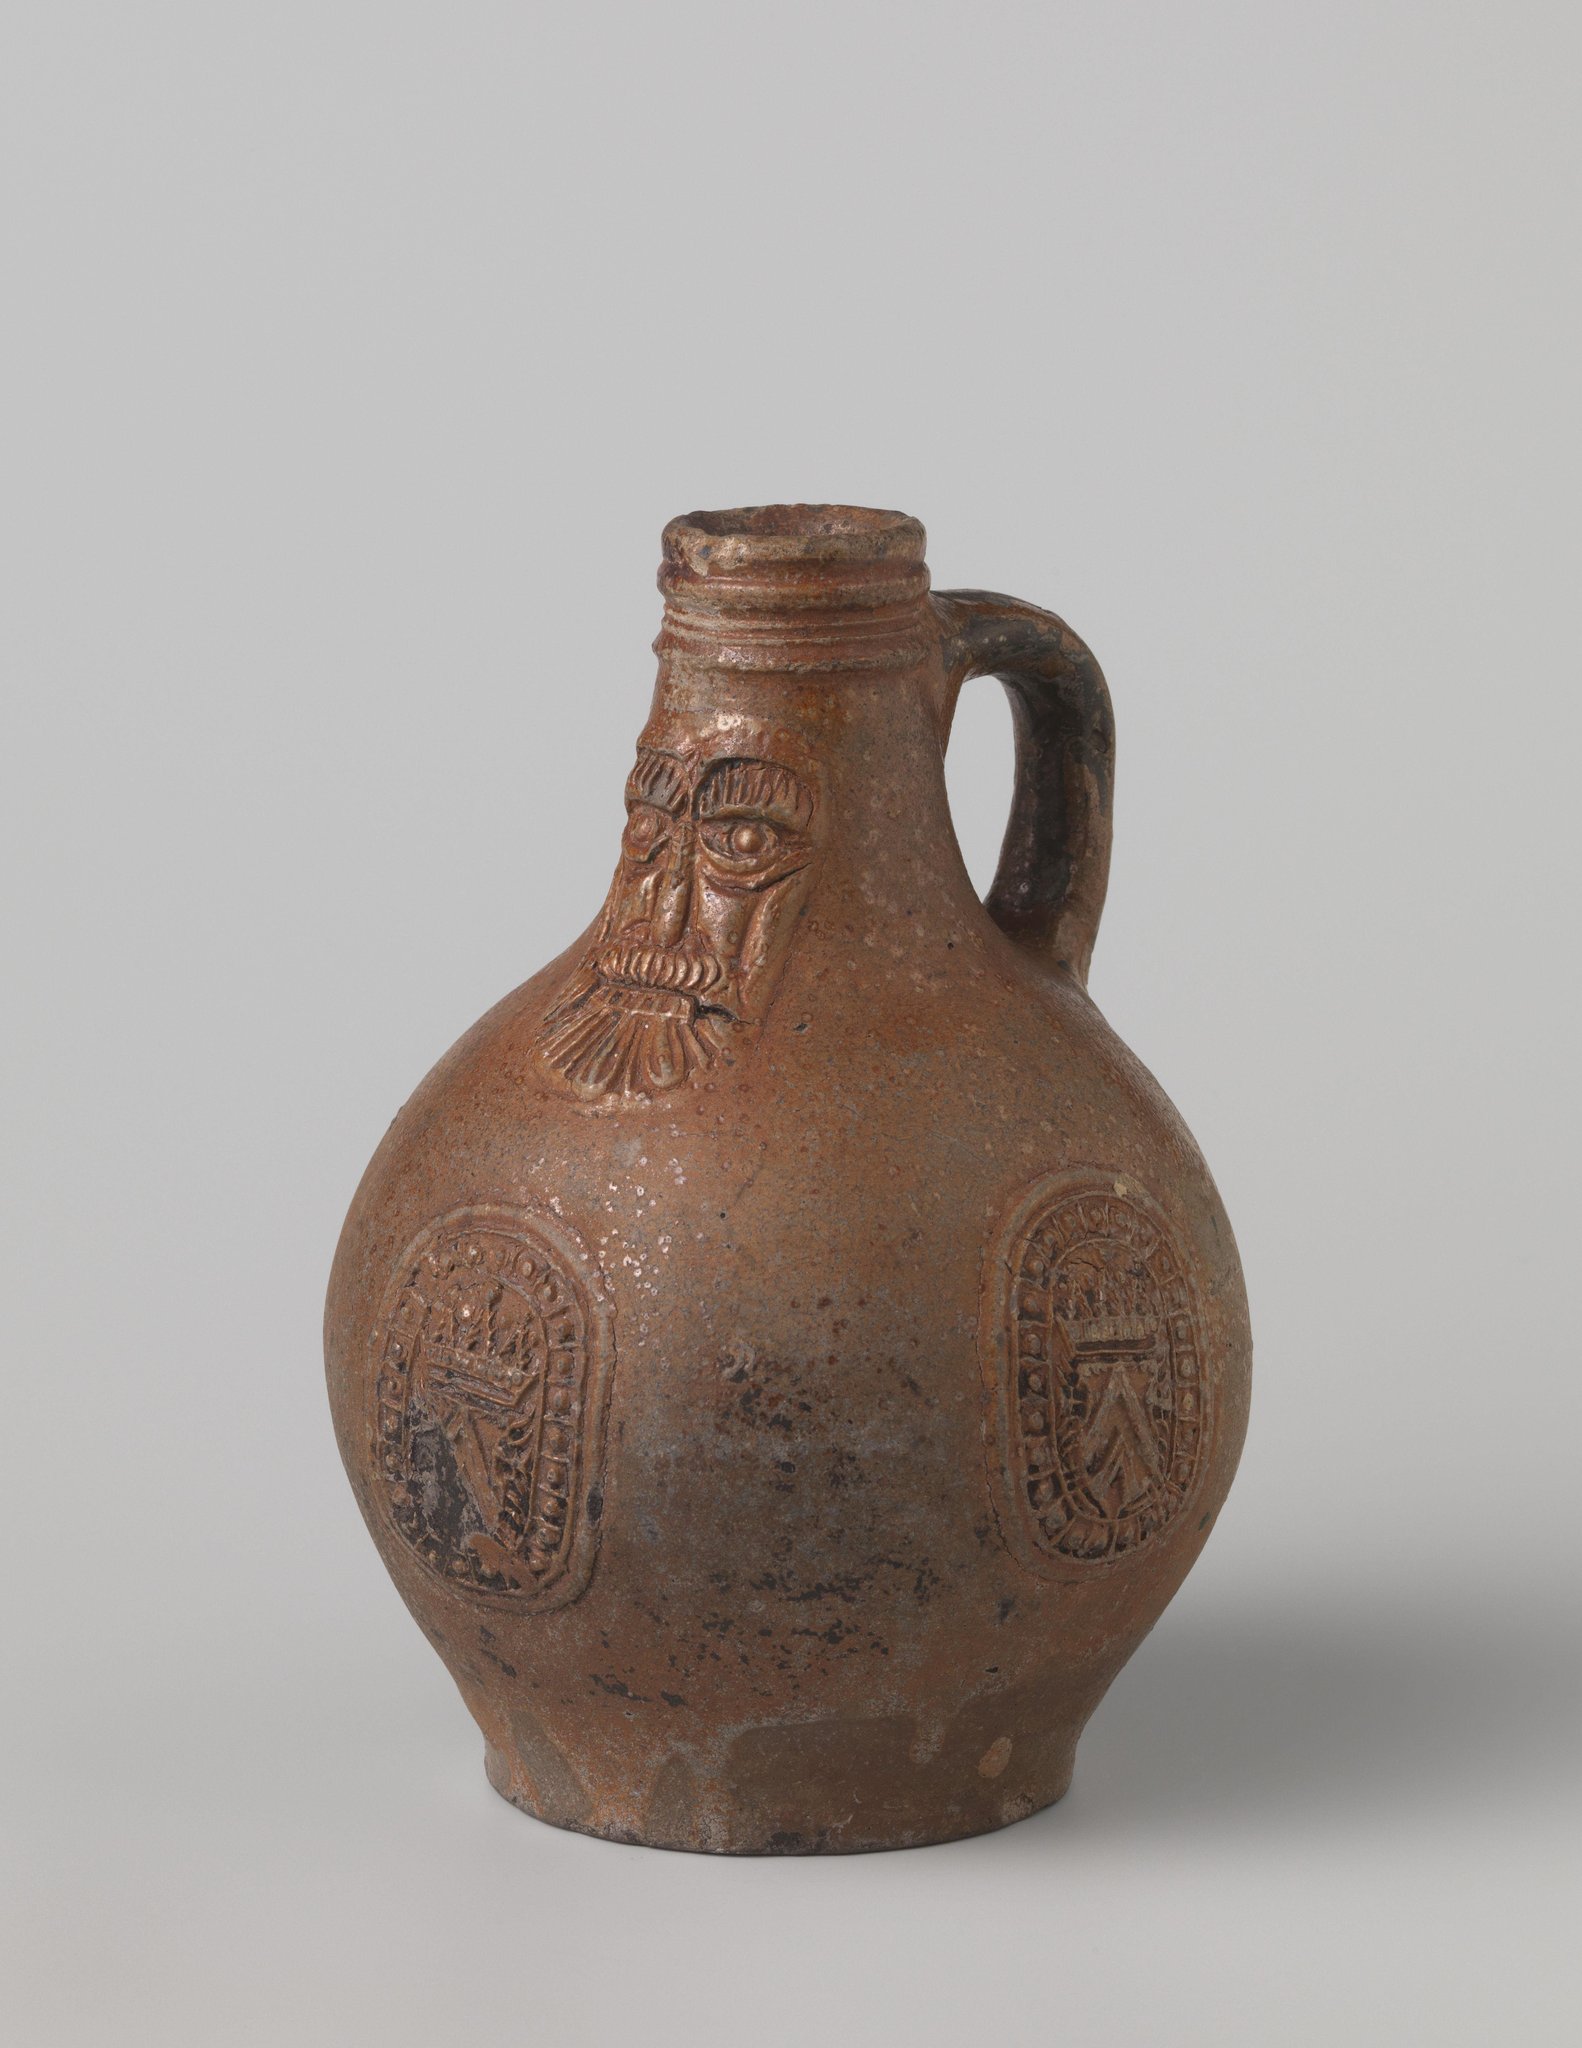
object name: jug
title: Jug (Bartmann jug) with a coat of arms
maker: Anonymous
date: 1625-1750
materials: engobe, glaze, stoneware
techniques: firing, forming, relief, turning, vitrification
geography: frechen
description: Kruik (baardmankruik) van steengoed op standvlak met een bolvormig lichaam en smalle nek. Het C-vormige oor is bevestigd aan de nek en de schouder. Profielen op de nek. Op de buik in reliëf driemaal een gedrukt en opgelegd medaillon met een gekroond wapen, omgeven door een band met bollen. Op de nek, doorlopend op de schouder, een baardman. Frechen.